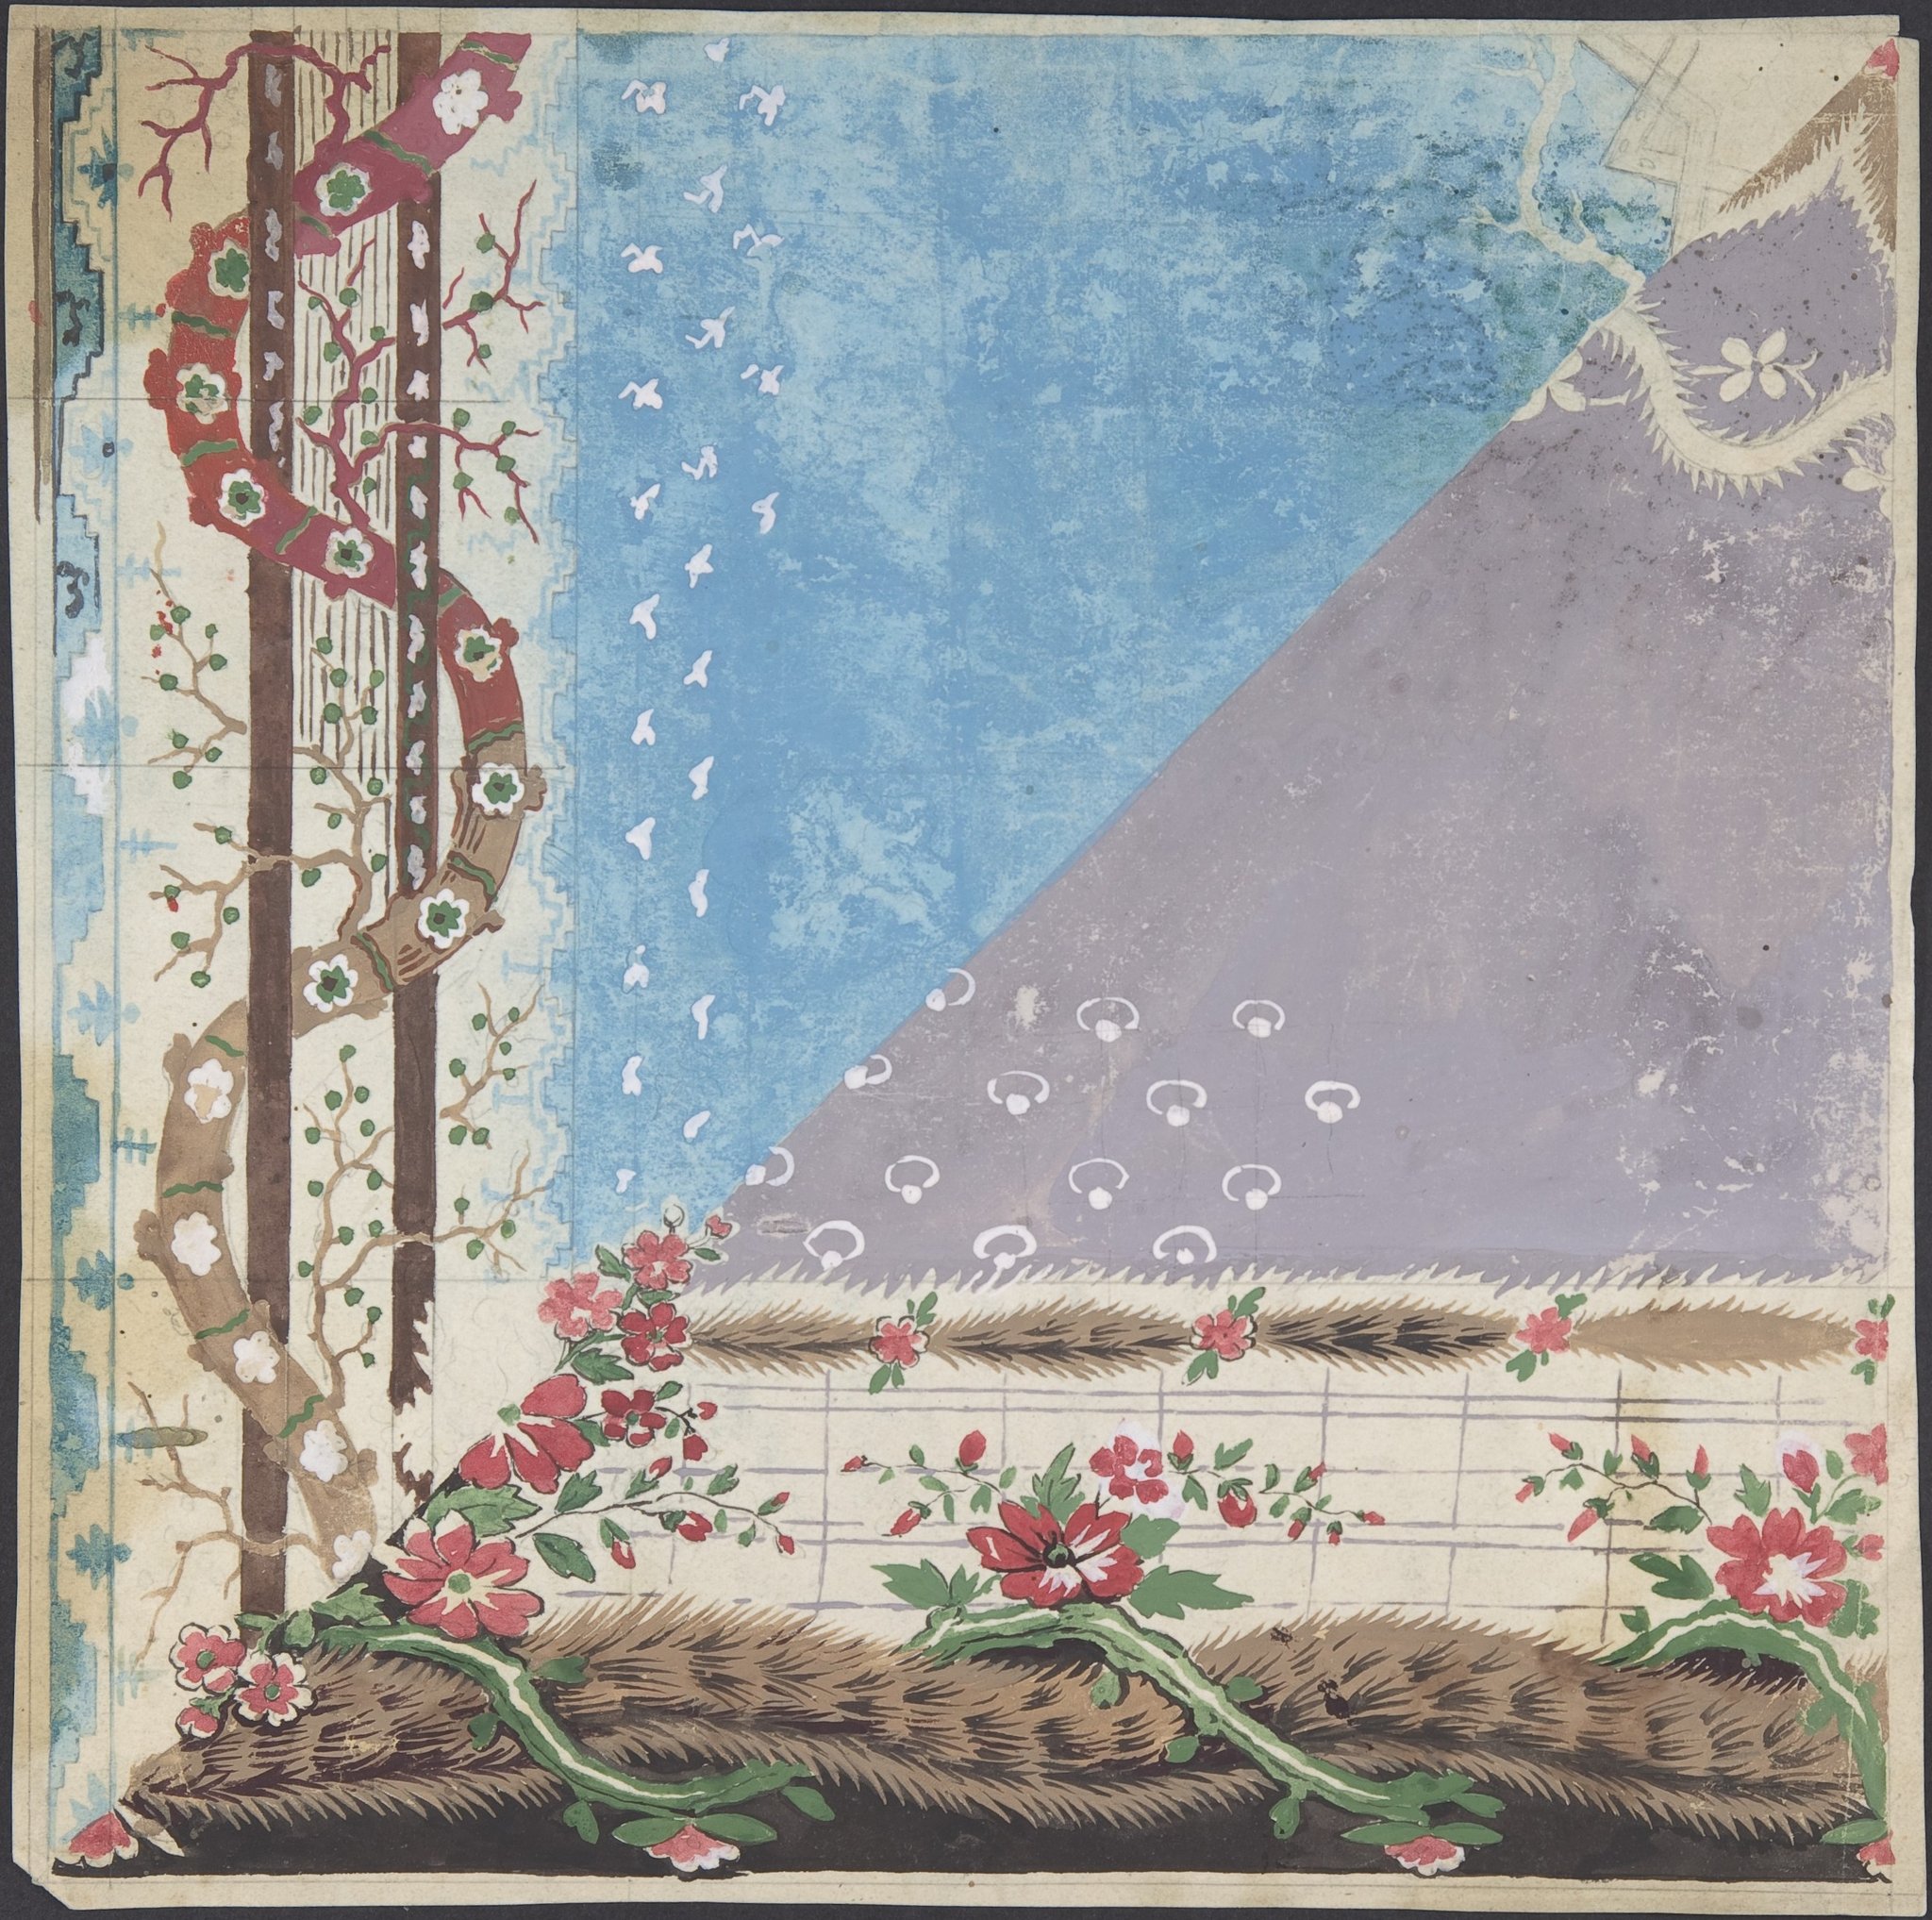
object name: drawing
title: Two Alternate Decorative Designs for Ceiling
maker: anonymous, french, 19th century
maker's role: artist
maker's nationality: french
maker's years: 1800-1900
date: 1801-1900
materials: gouache, graphite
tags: ornament,ceilings